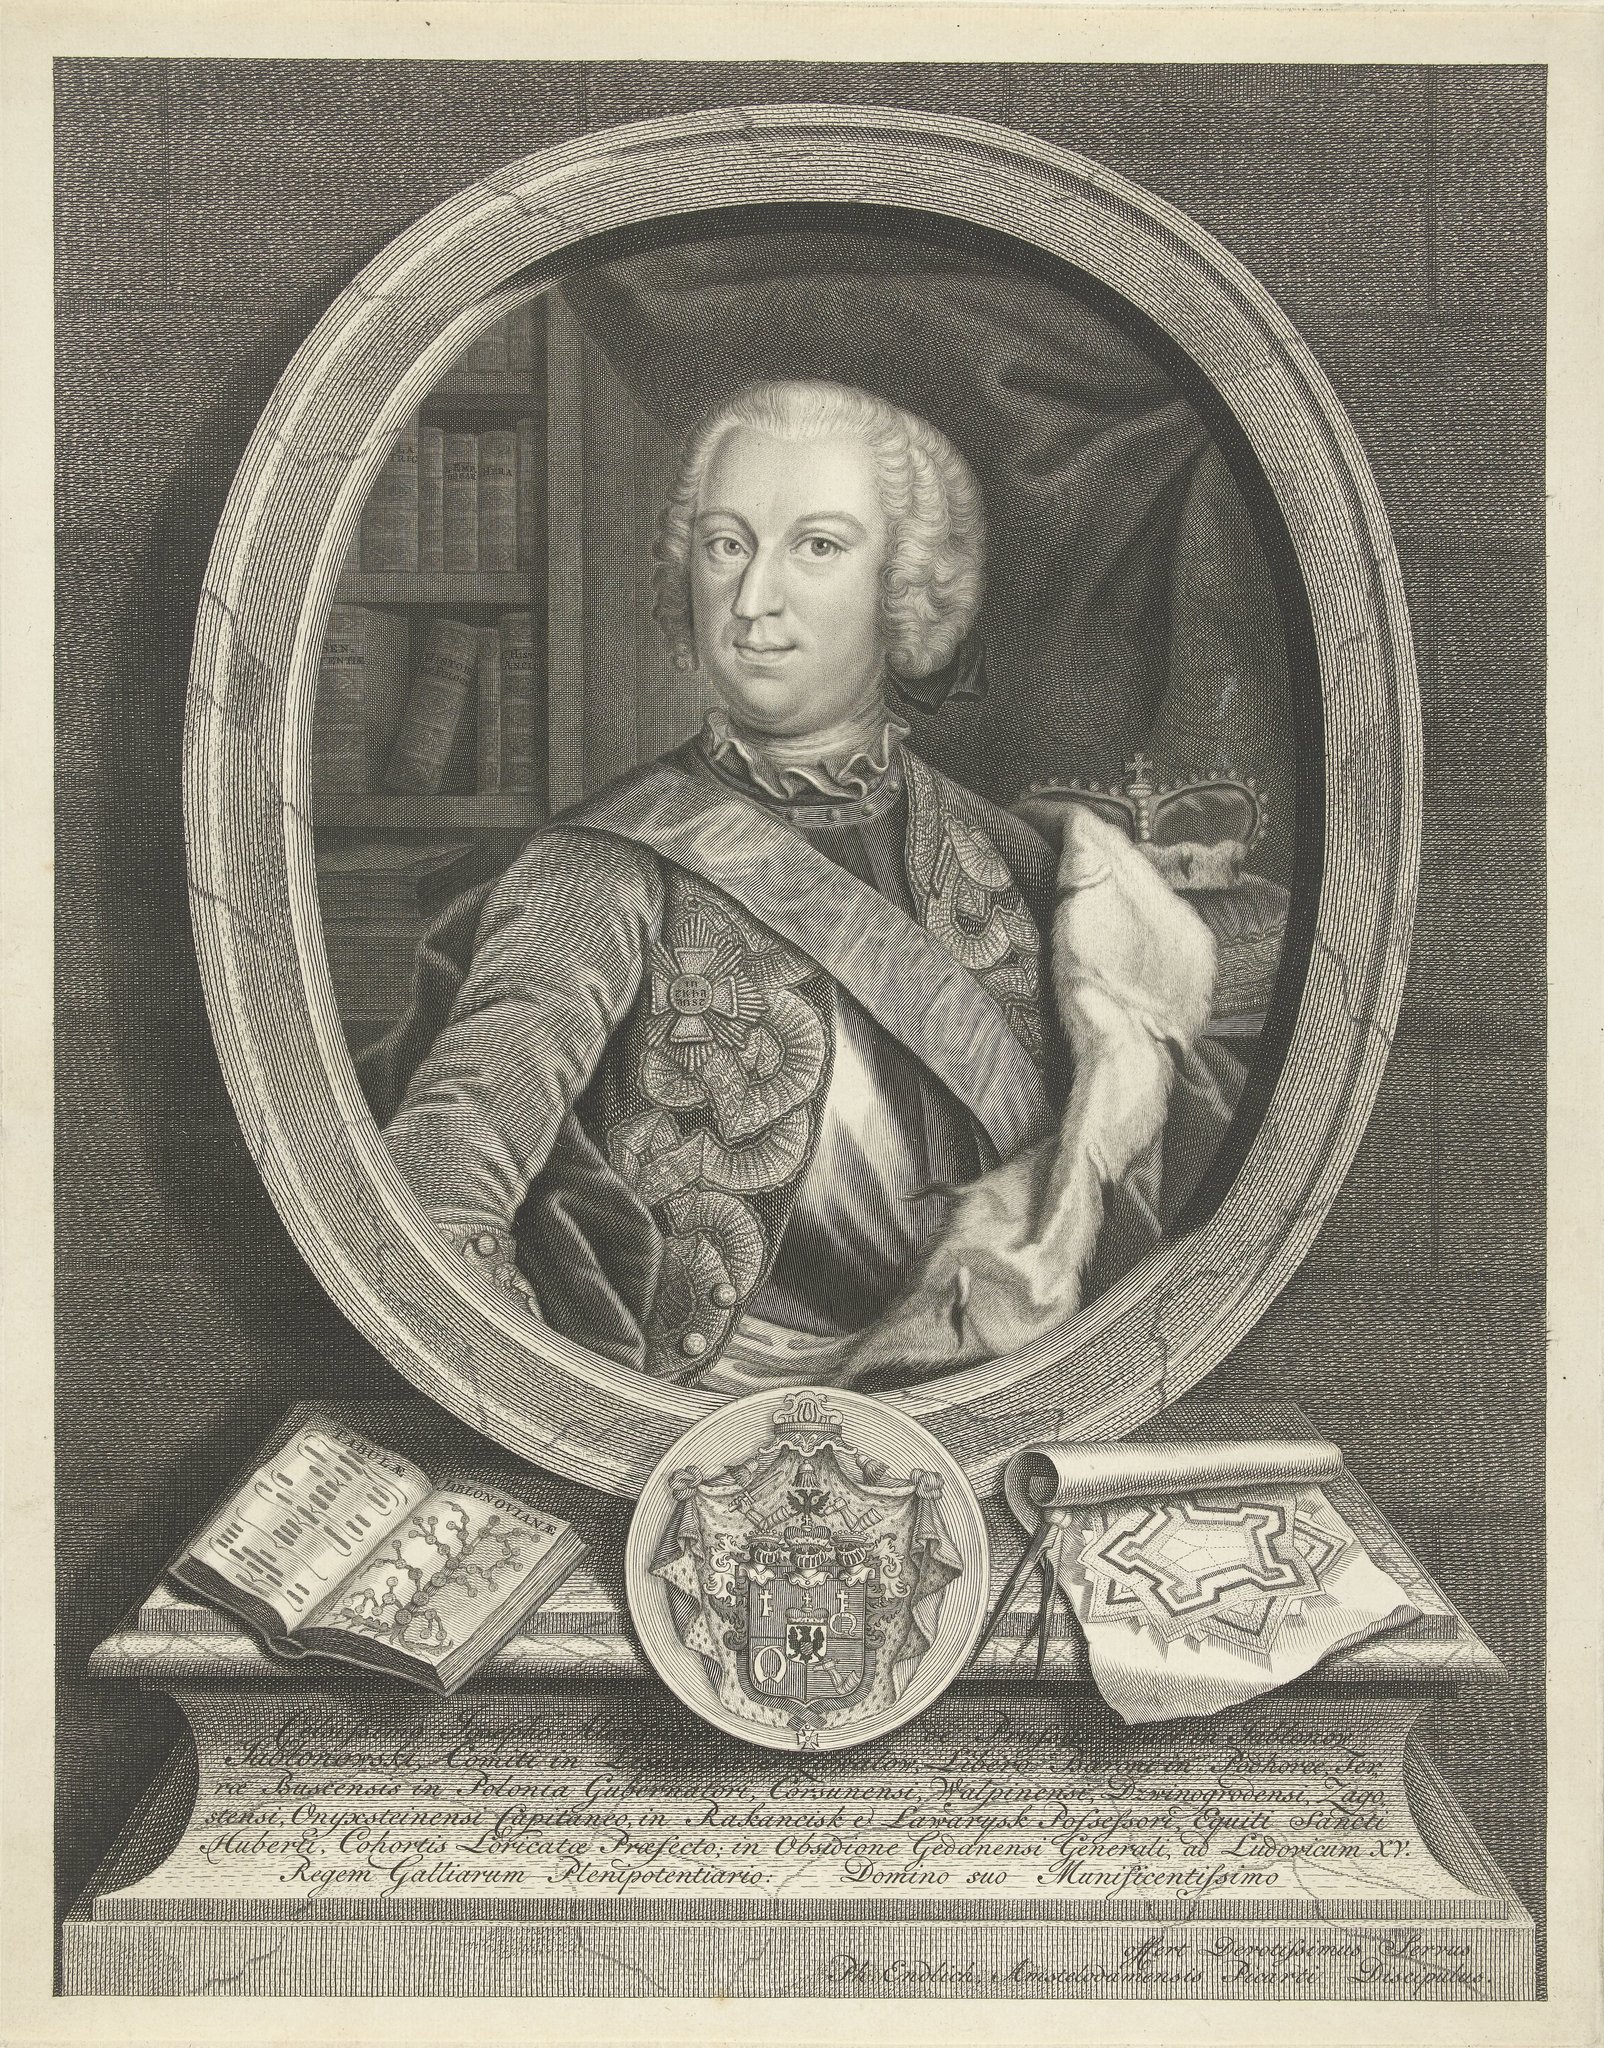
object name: print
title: Portret Józef Aleksander Jablonowski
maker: philippus endlich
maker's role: draughtsman, print maker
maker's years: 1700-1748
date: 1731-1748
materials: paper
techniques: engraving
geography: amsterdam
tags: prins, józef aleksander jablonowski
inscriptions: collector's mark: Lugt 2228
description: Portret van de Poolse prins Józef Aleksander Jablonowski (1711–1777) met bontmantel over de schouder en kroon op de achtergrond. Afgebeeld in ovale omlijsting op console met zes regels Latijn, wapen, opengeslagen boek en passer.